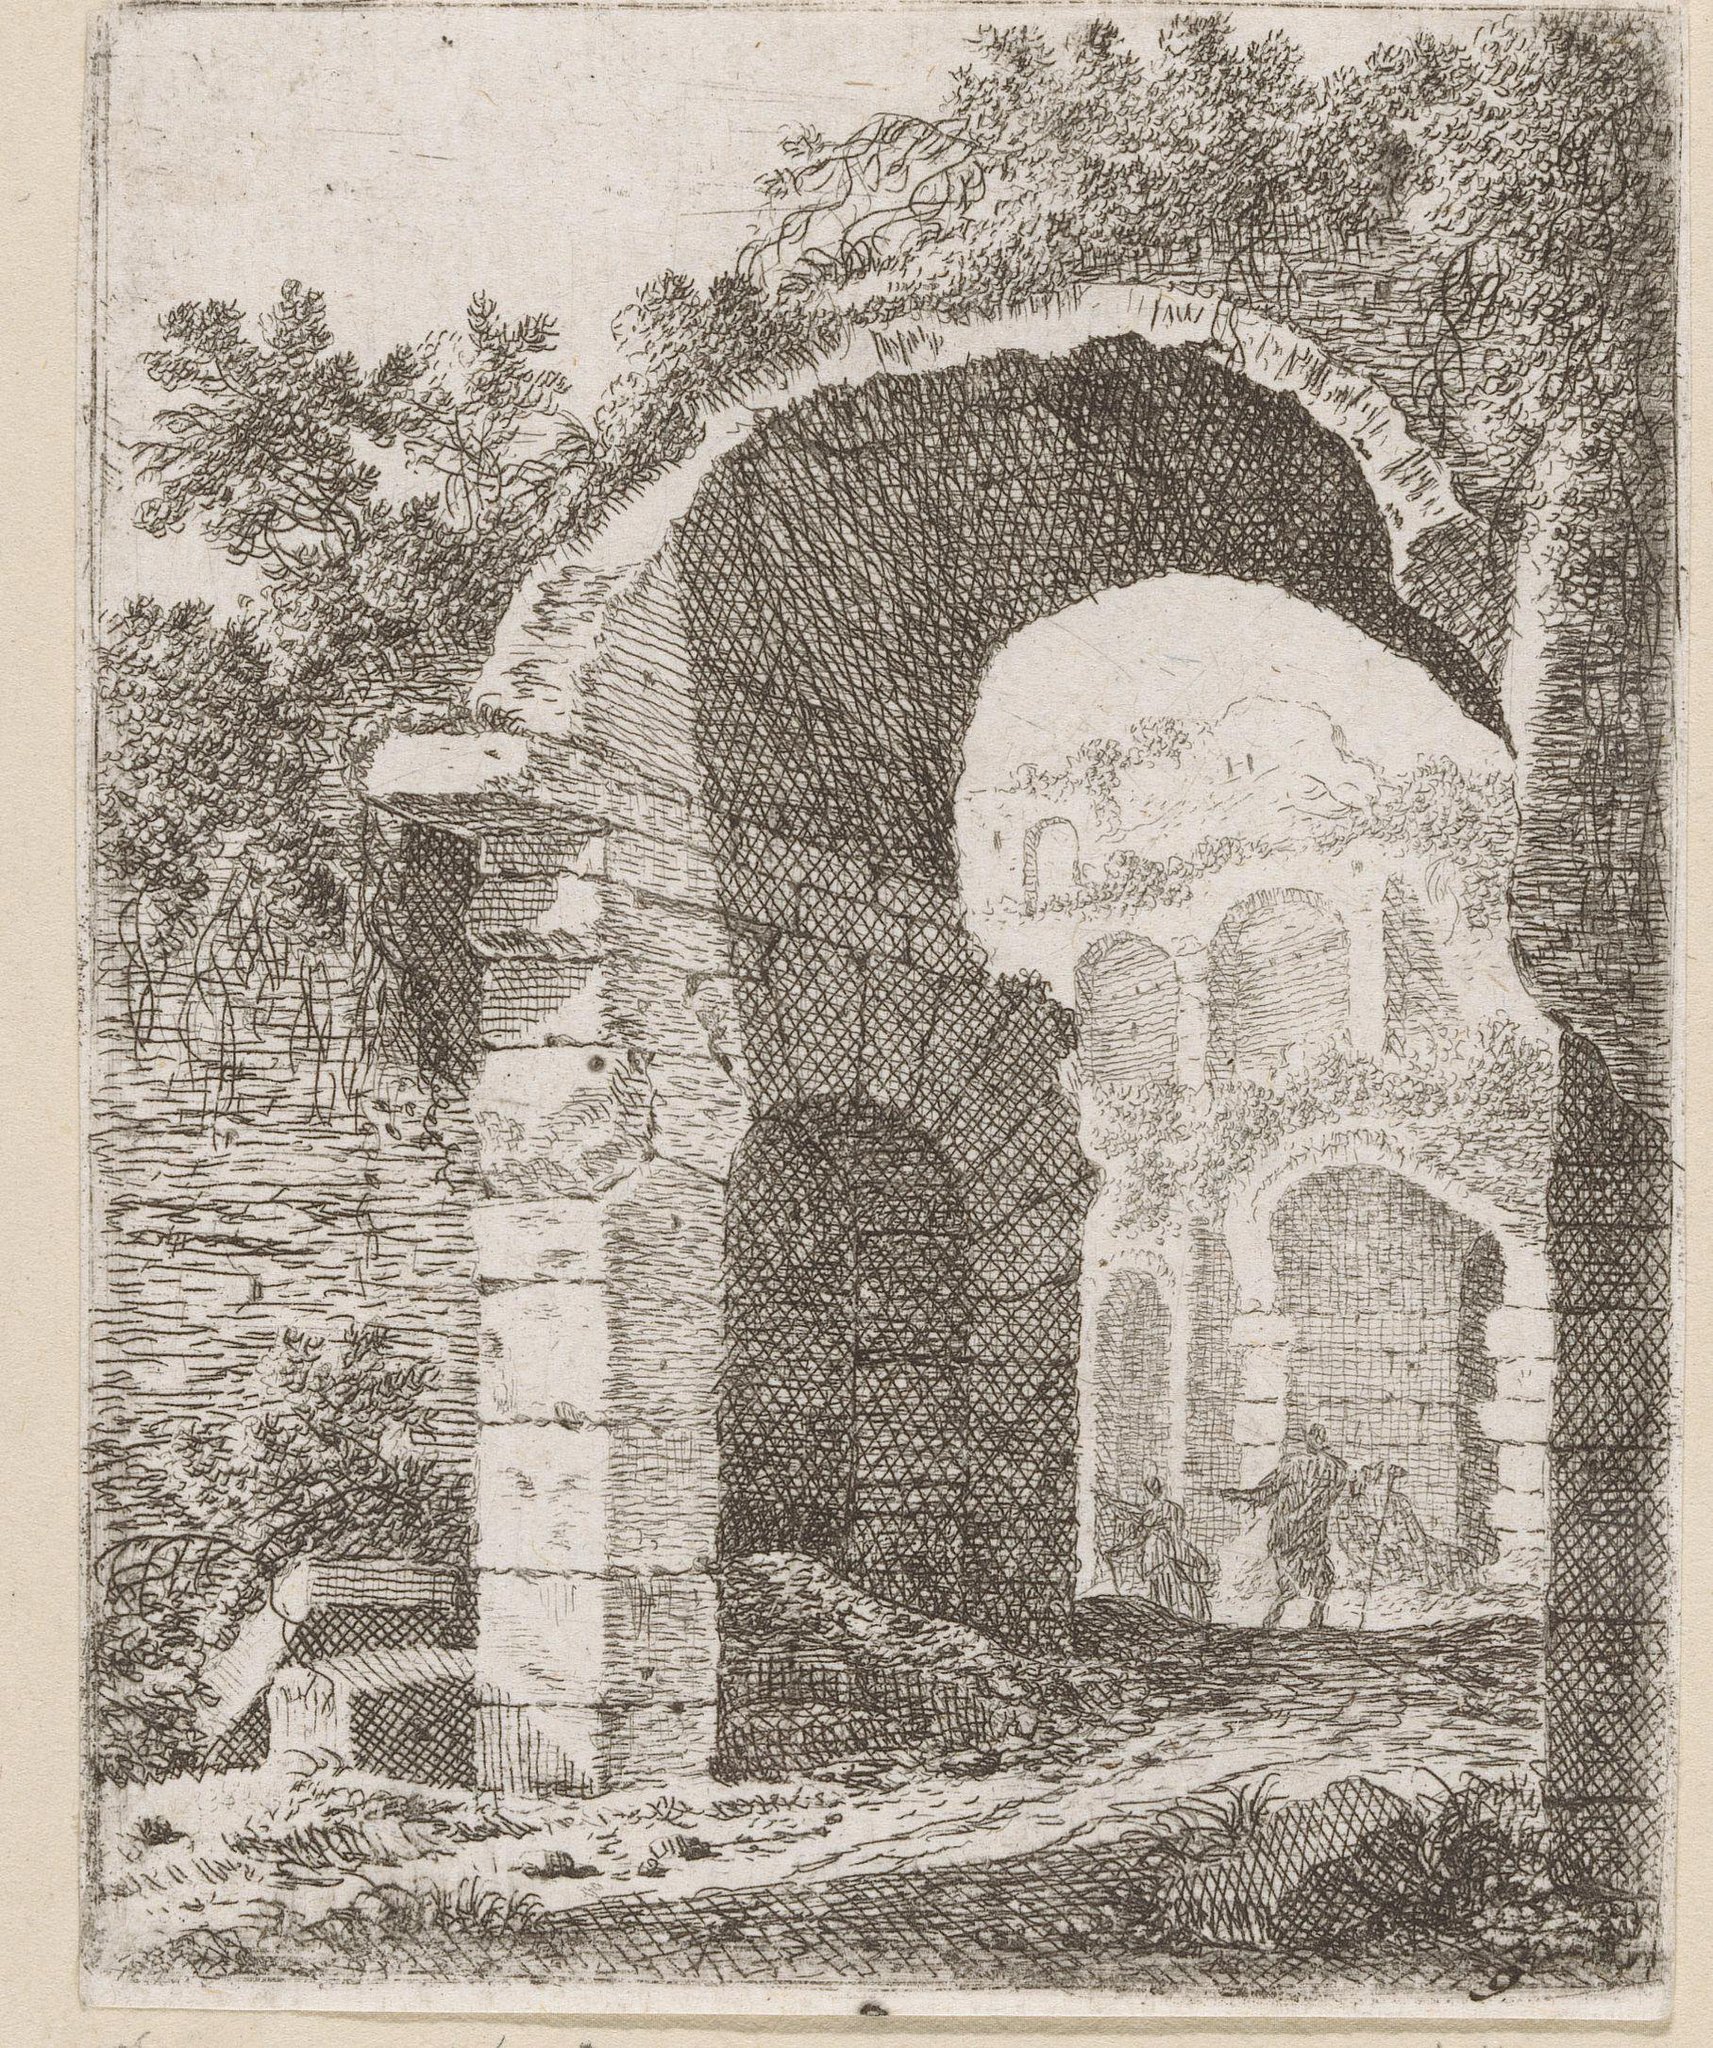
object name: print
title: Ruïne van een portico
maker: johann franz ermels (der ältere)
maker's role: draughtsman, print maker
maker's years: 1641-1693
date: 1651-1693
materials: paper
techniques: etching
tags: landscape with ruins, arcade ~ architecture, rome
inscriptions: collector's mark: Lugt 2228